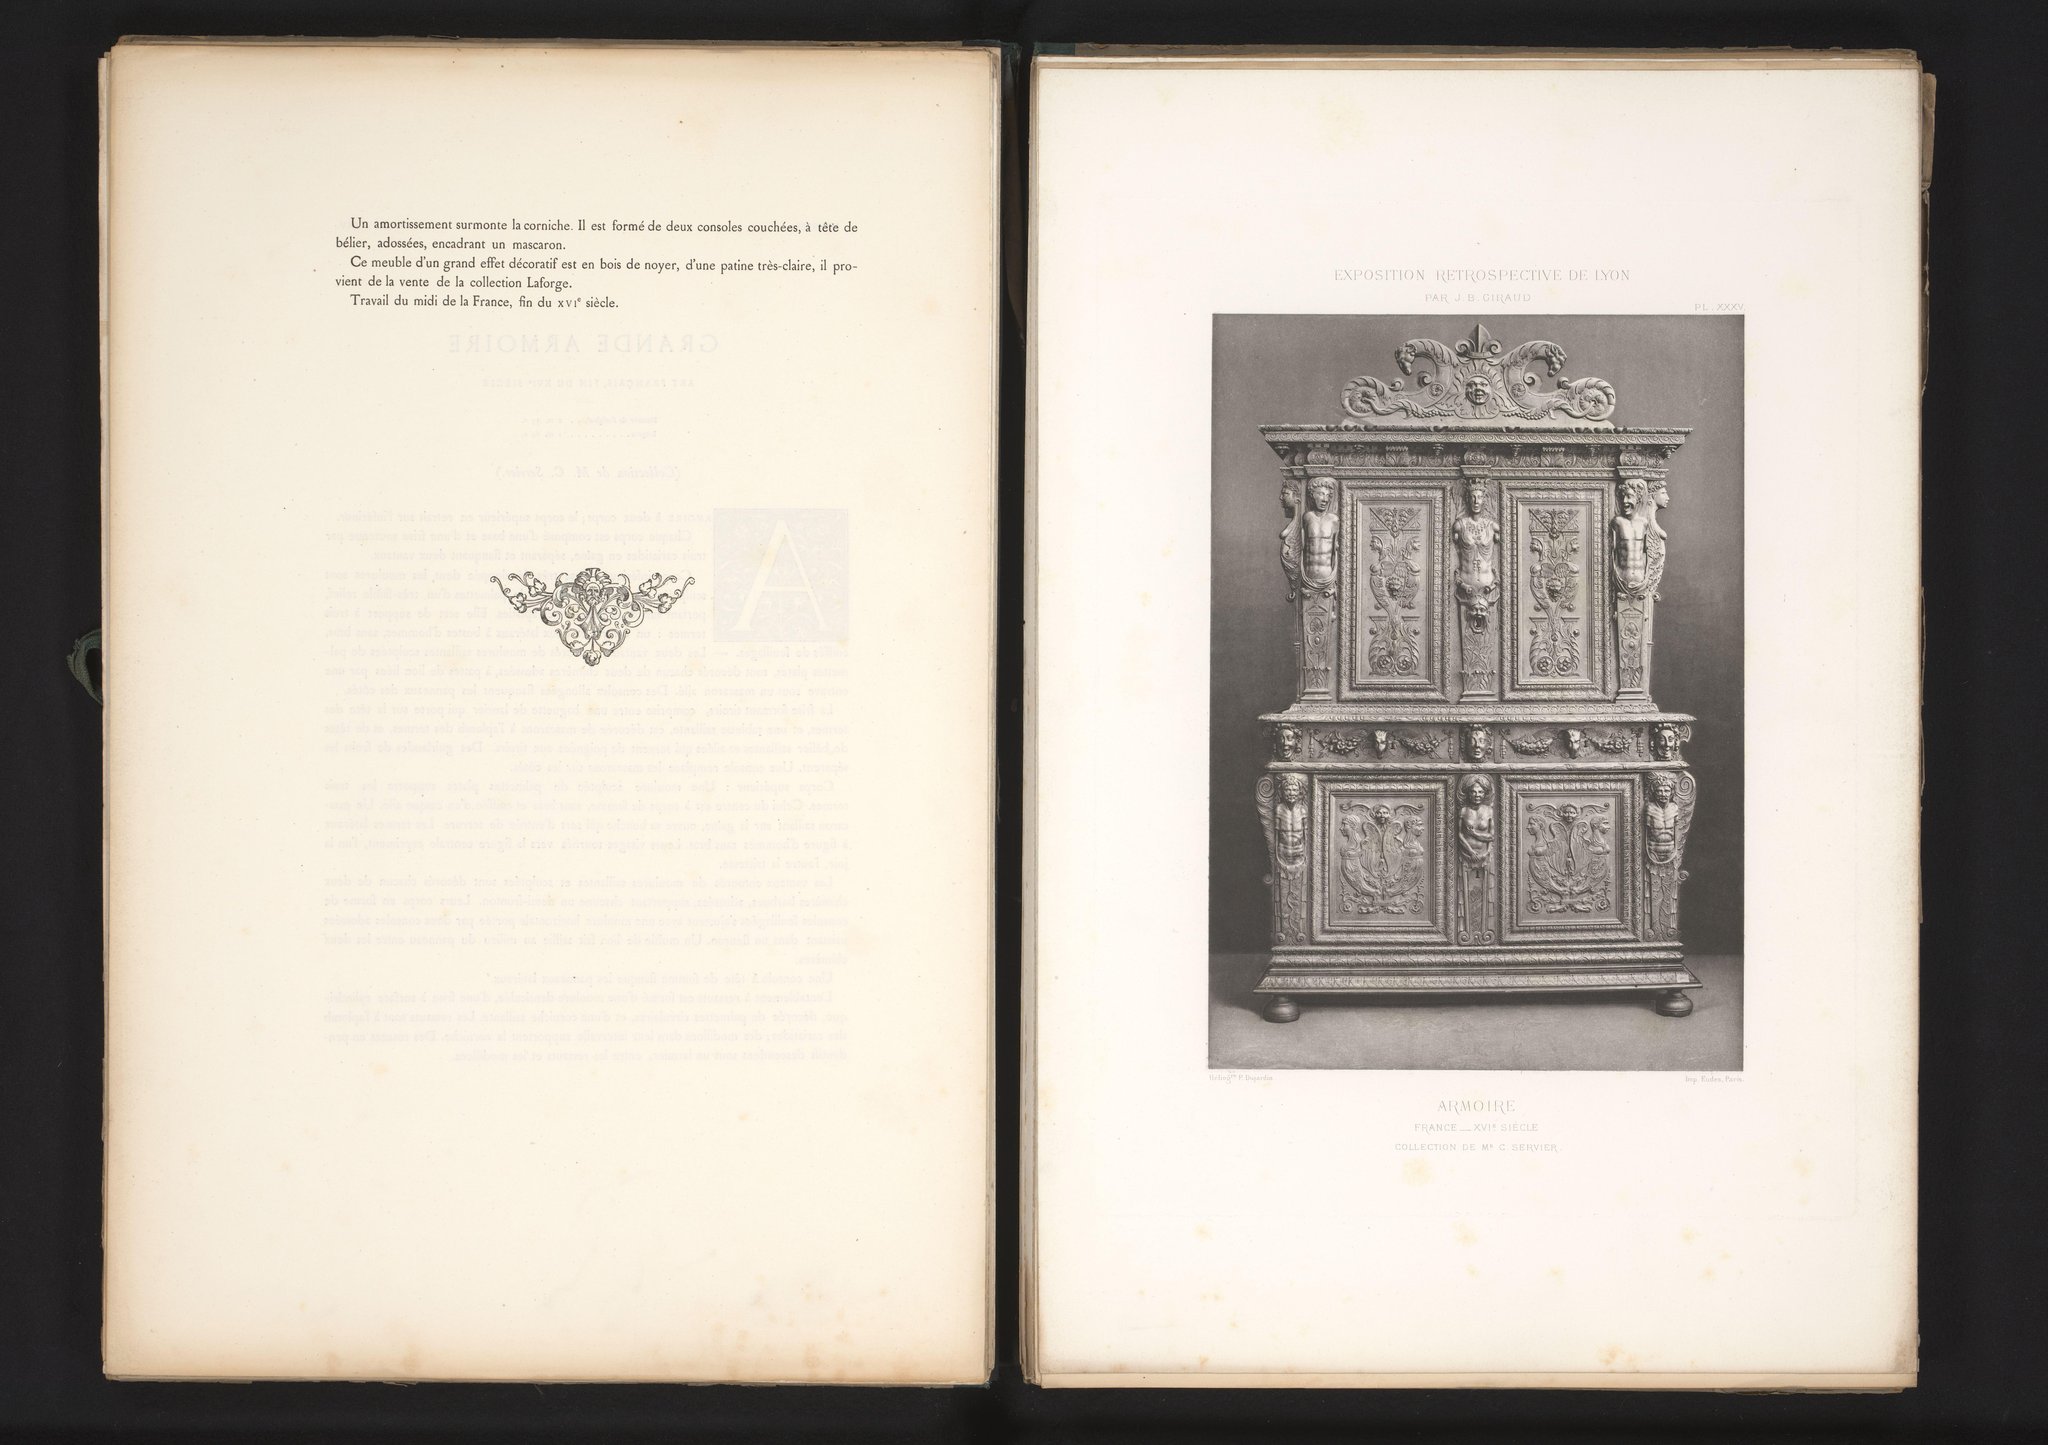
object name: photomechanical print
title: 16de-eeuwse Franse kast van hout, op de Exposition Rétrospective van 1877 in Lyon, Frankrijk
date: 1877-1878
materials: paper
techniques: photoaquatint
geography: paris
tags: ornamental cupboard (+ wood and other phytogenic material), lyon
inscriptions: inscription: ‘EXPOSITION RÉTROSPECTIVE DE LYON/ PAR J. B. GIRAUD.’, inscription: ‘ARMOIRE/ FRANCE_XVIe SIÈCLE/ COLLECTION DE Mr C. SERVIER.’, number: ‘PL. XXXV.’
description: Deze prent maakt deel uit van een omslag met 79 prenten op 54 bladen en 65 tekstbladen.